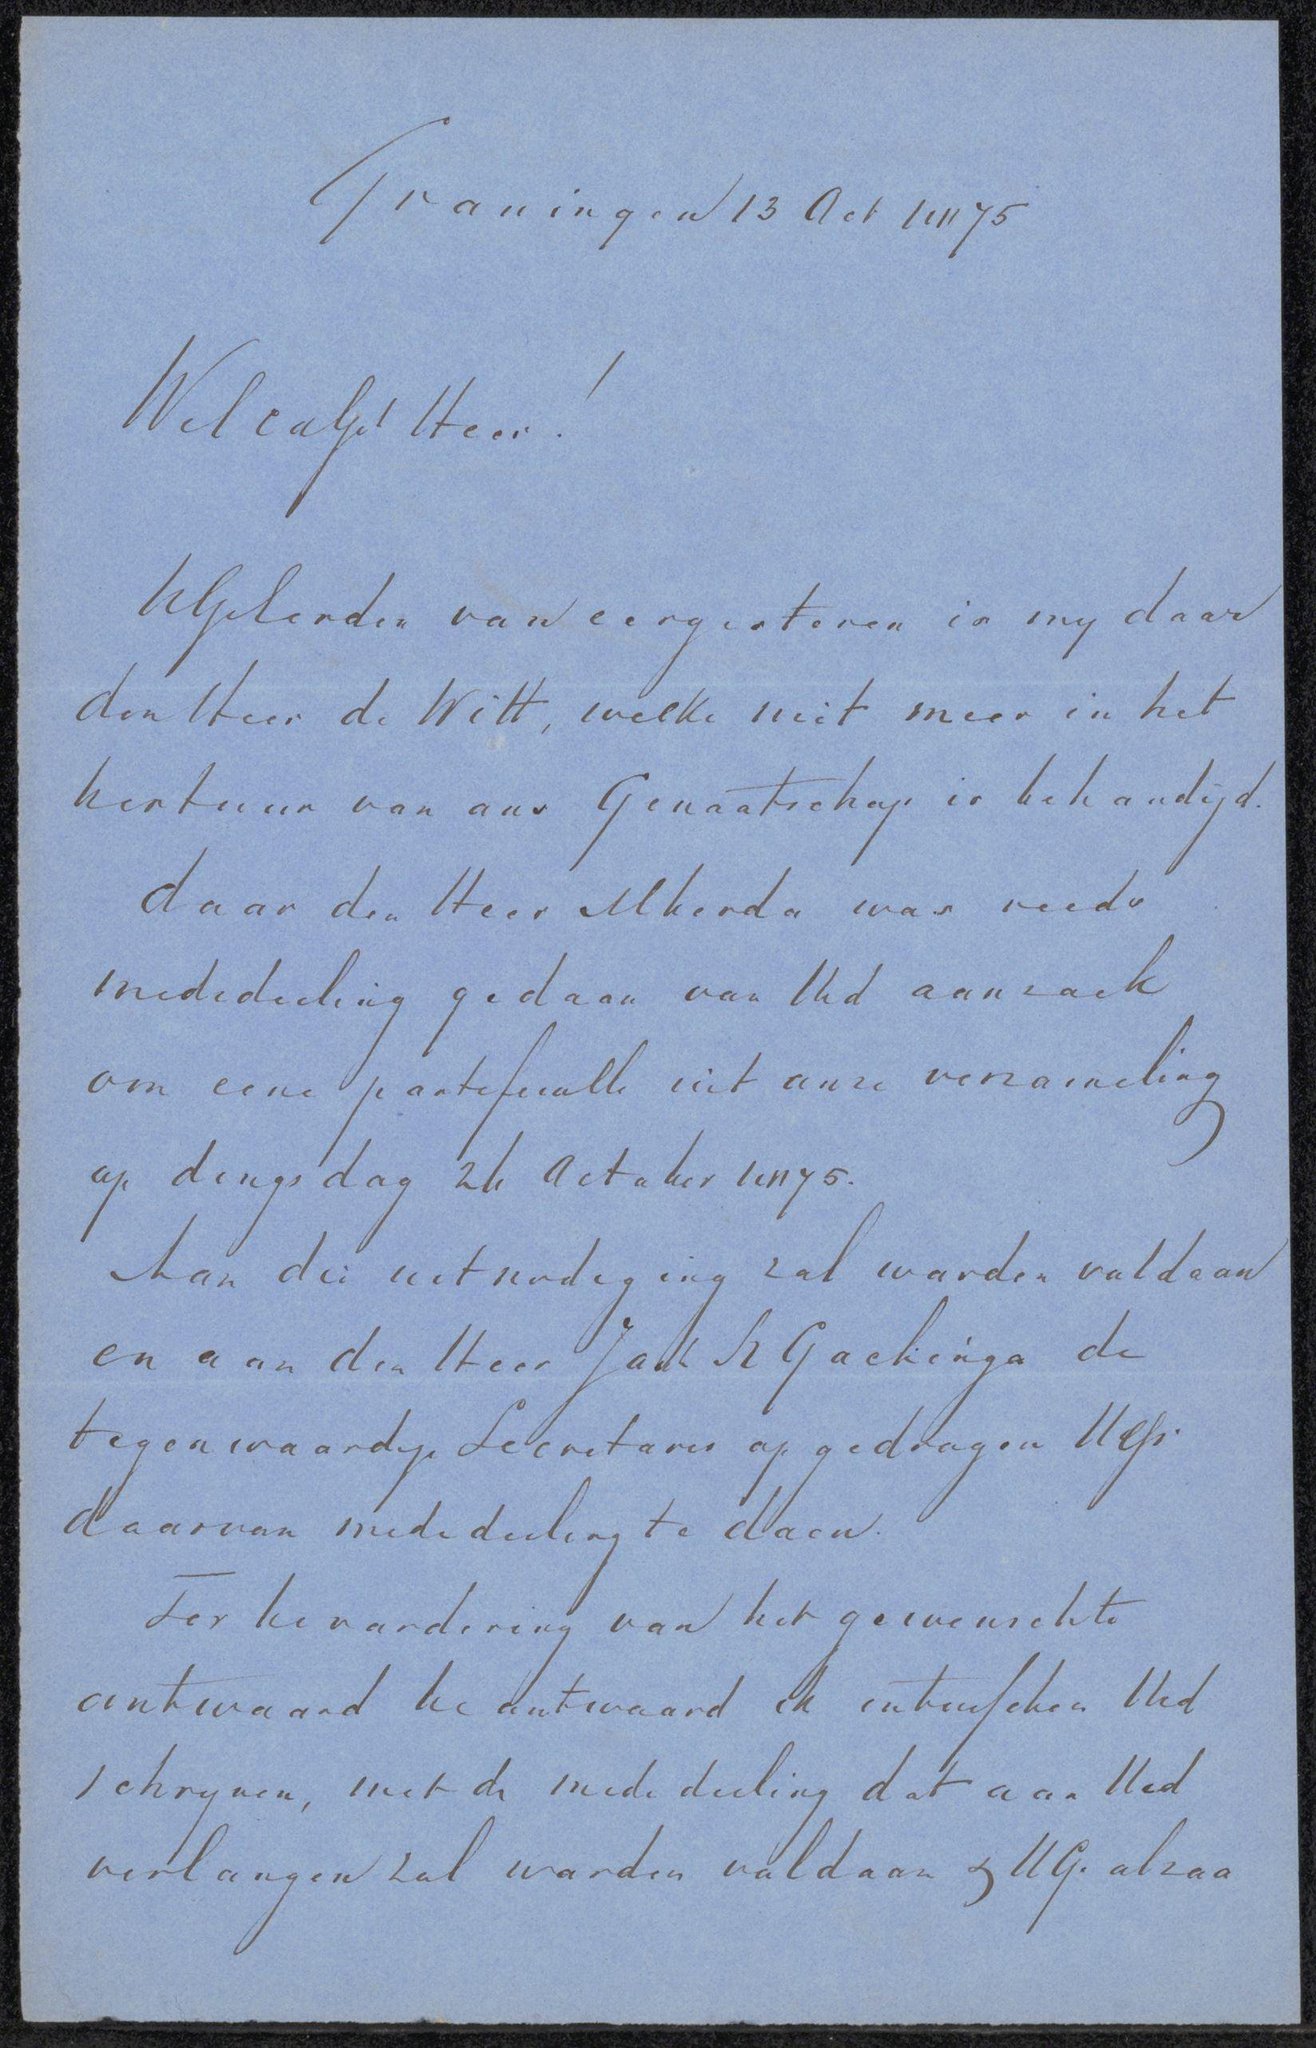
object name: letter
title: Brief aan anoniem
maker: taco mesdag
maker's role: draughtsman, painter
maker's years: 1829-1902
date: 1875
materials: ink, paper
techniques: pen, writing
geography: groningen